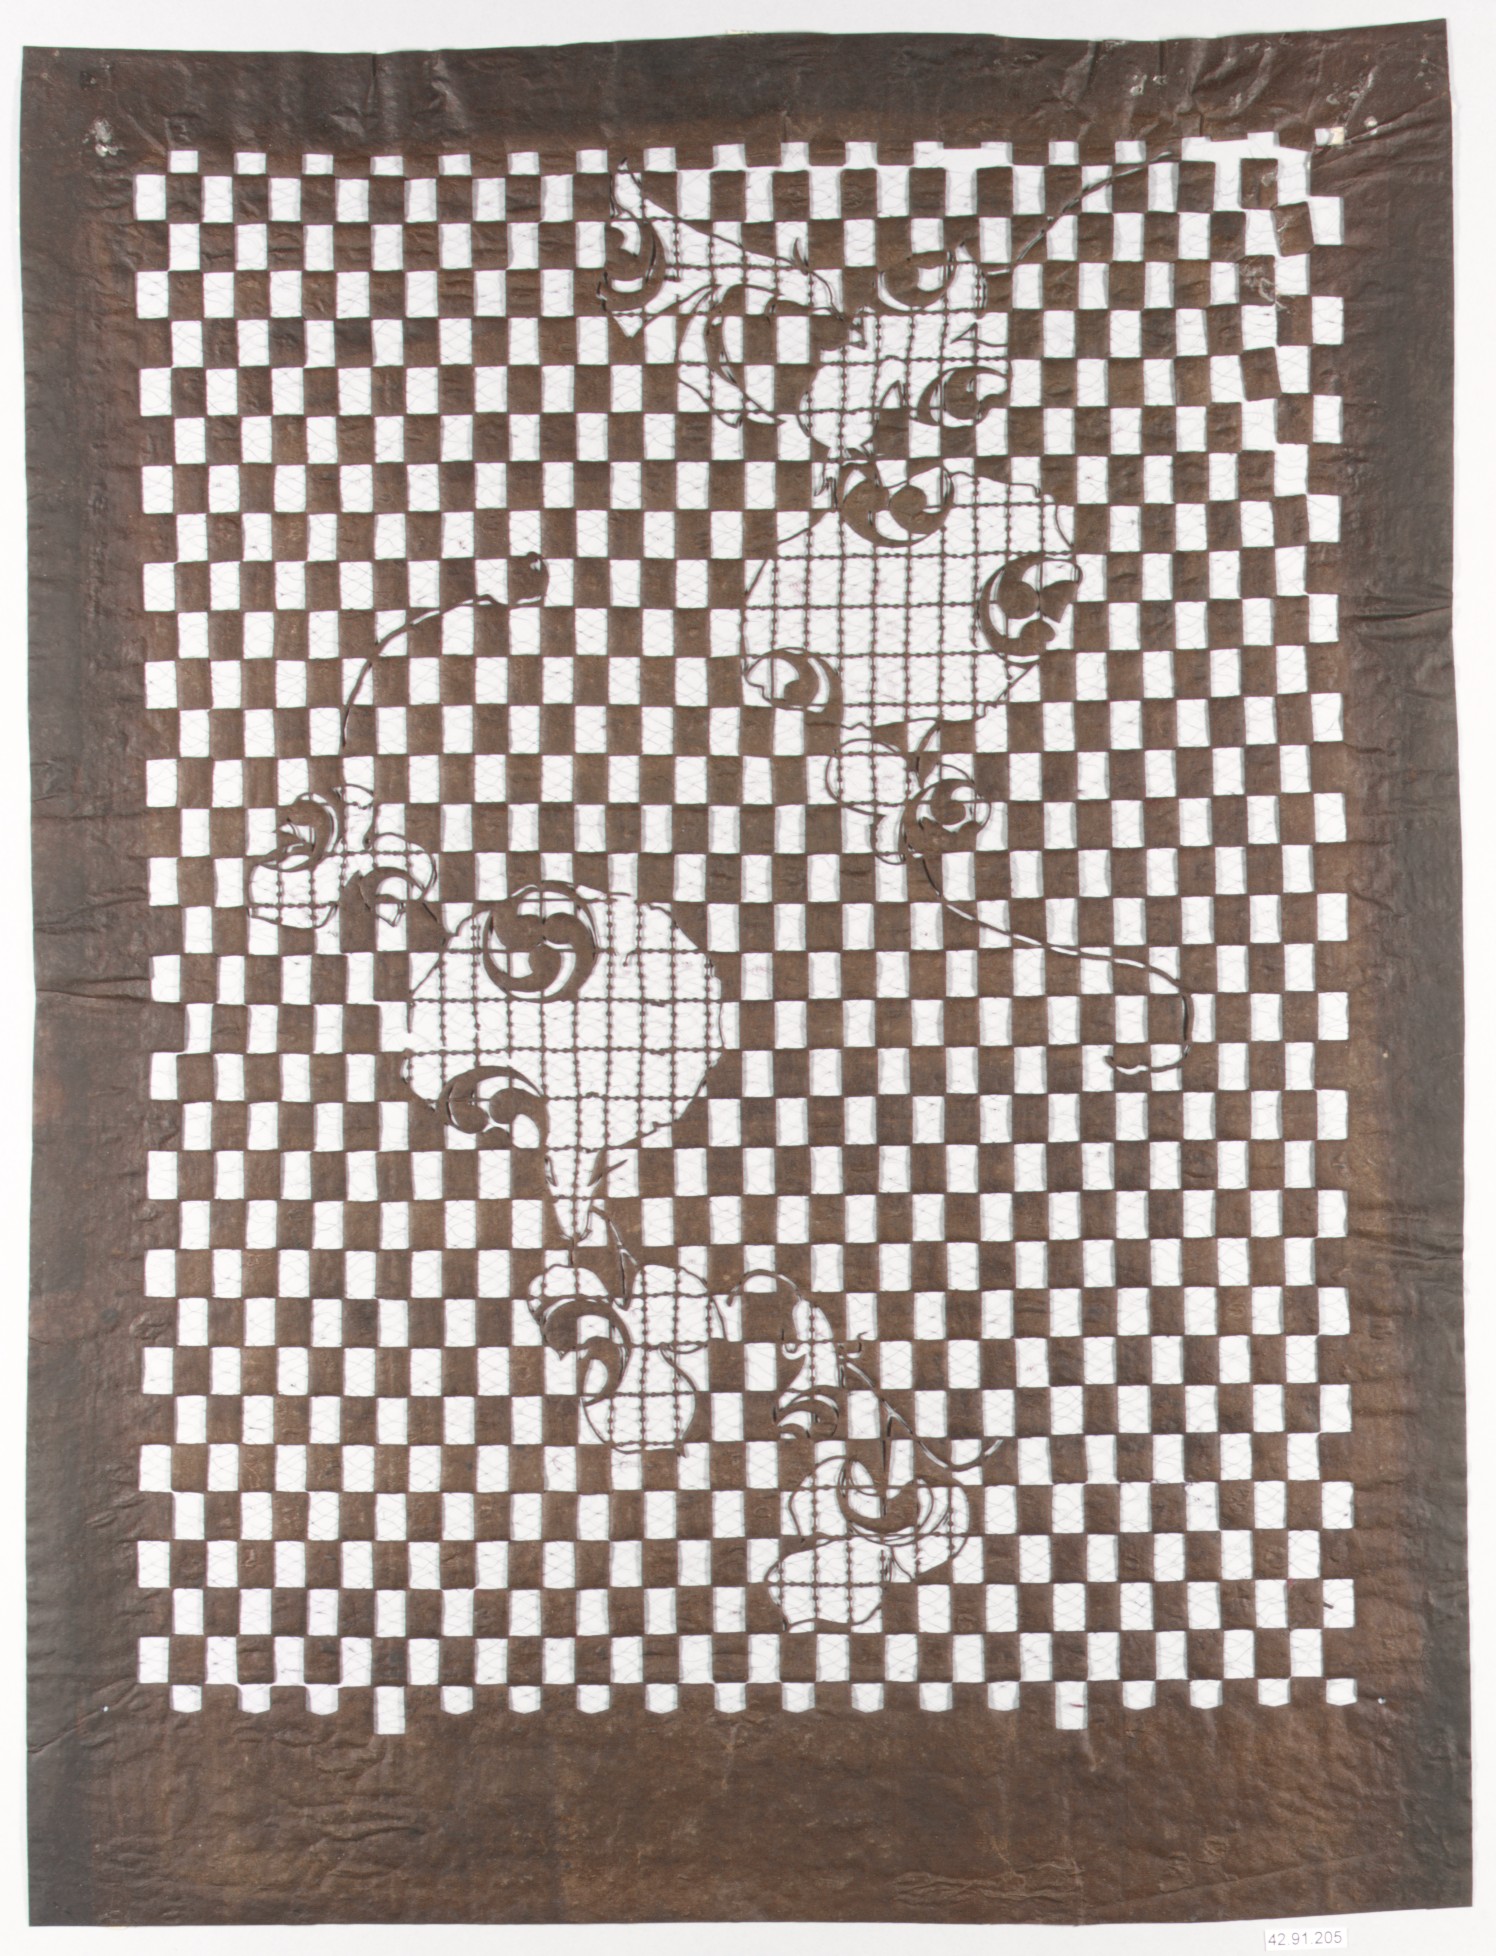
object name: stencil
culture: japanese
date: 1801-1900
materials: paper, silk